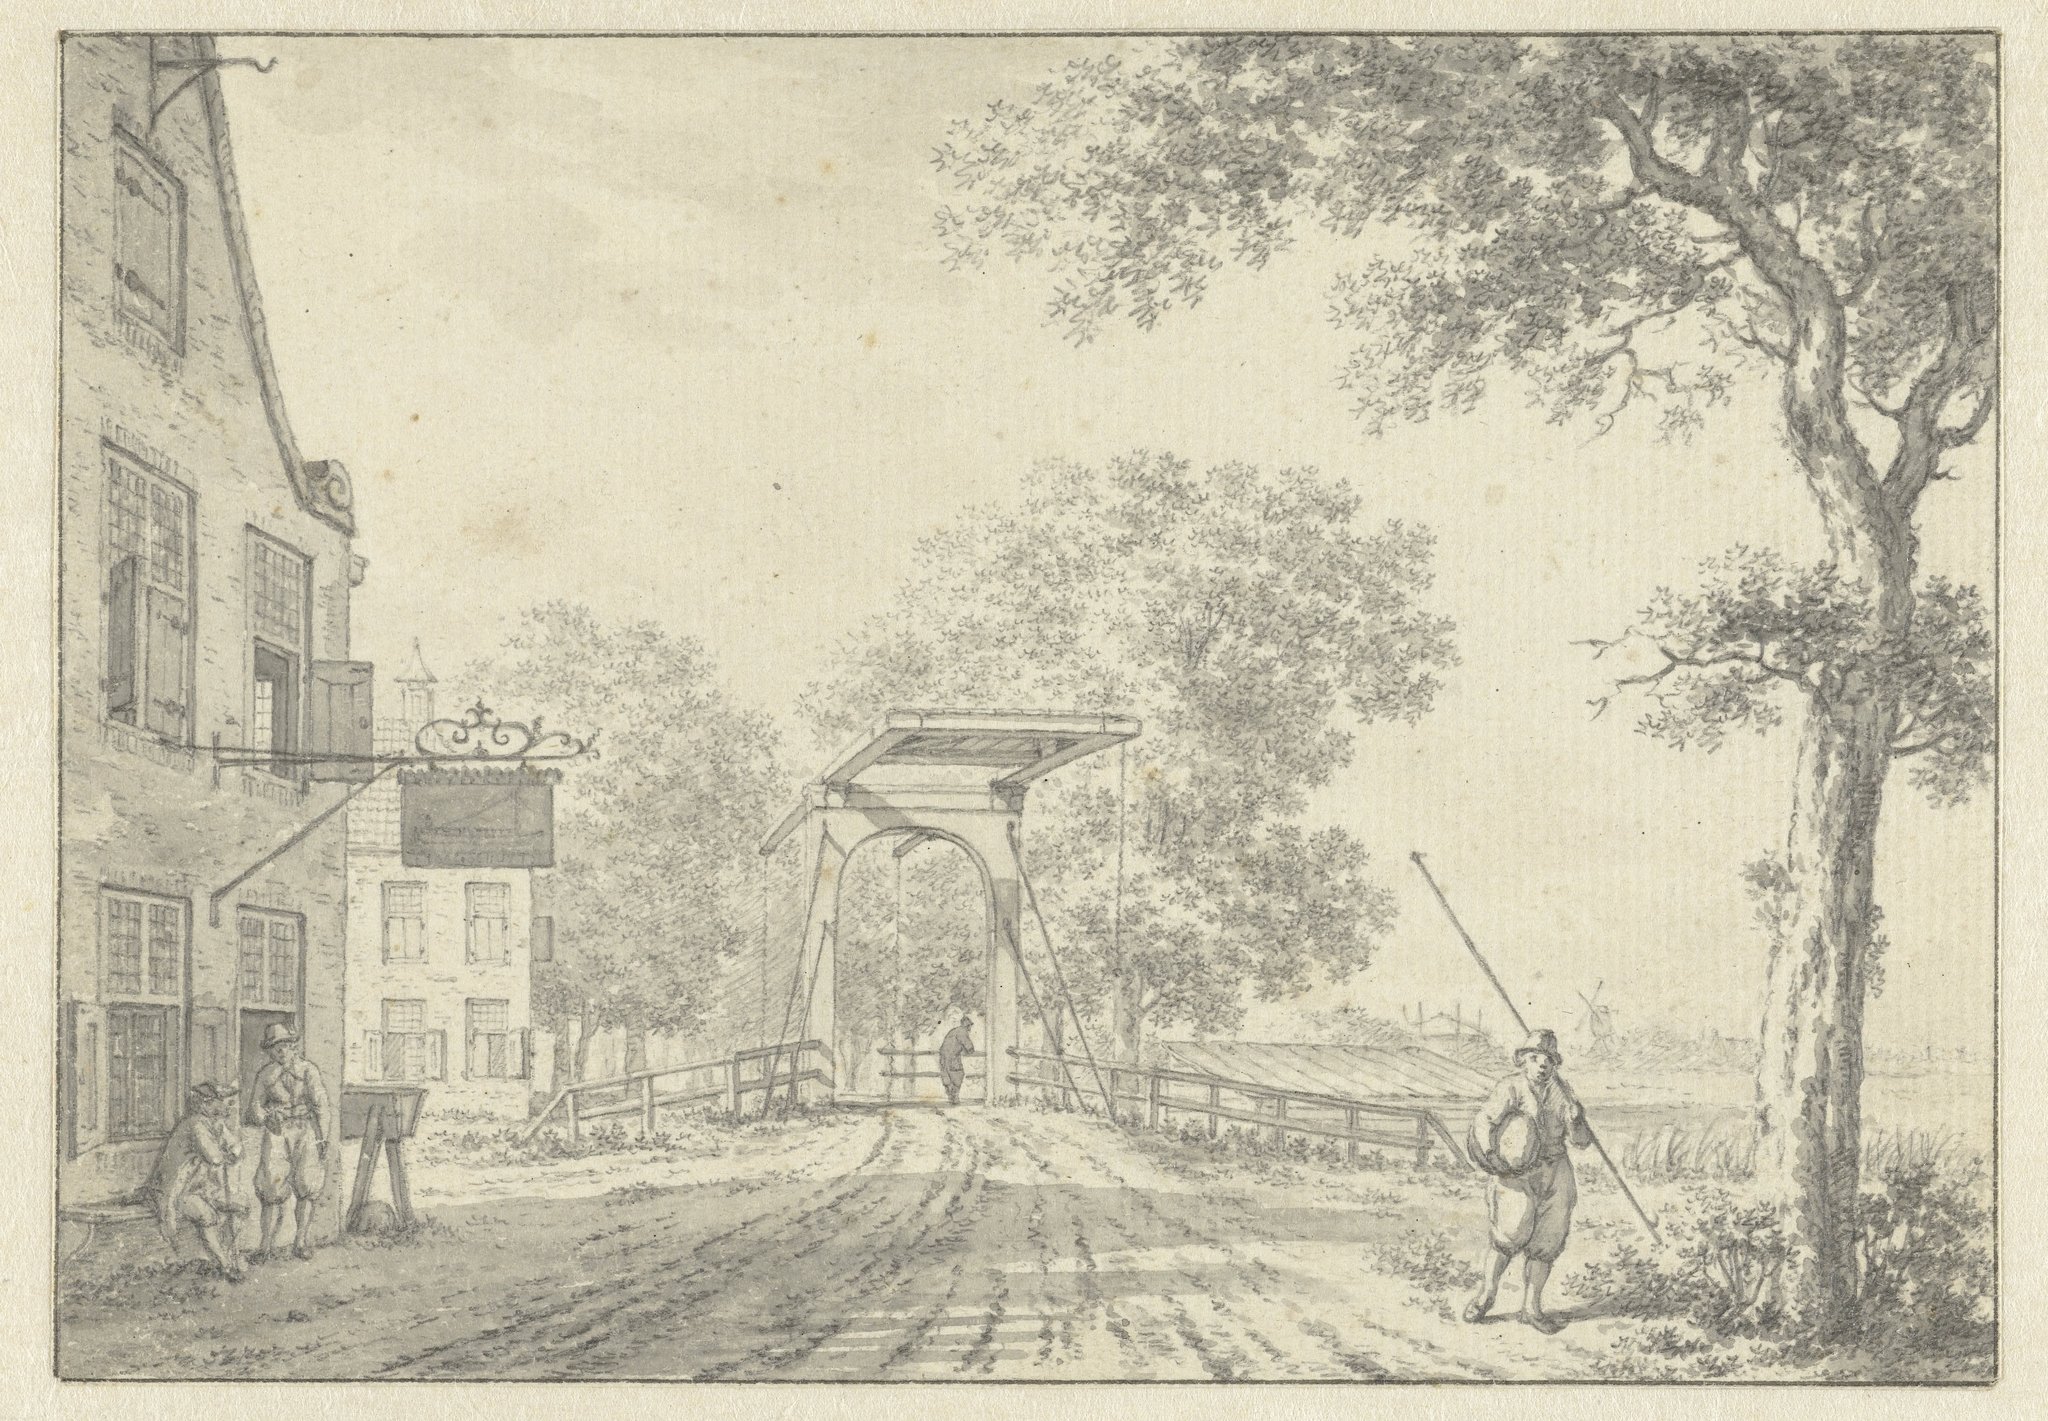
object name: drawing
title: Landschap met ophaalbrug en personen voor een herberg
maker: jacob cats (1741-1799)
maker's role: draughtsman, print maker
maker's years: 1741-1799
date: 1771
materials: paper, pencil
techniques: brush